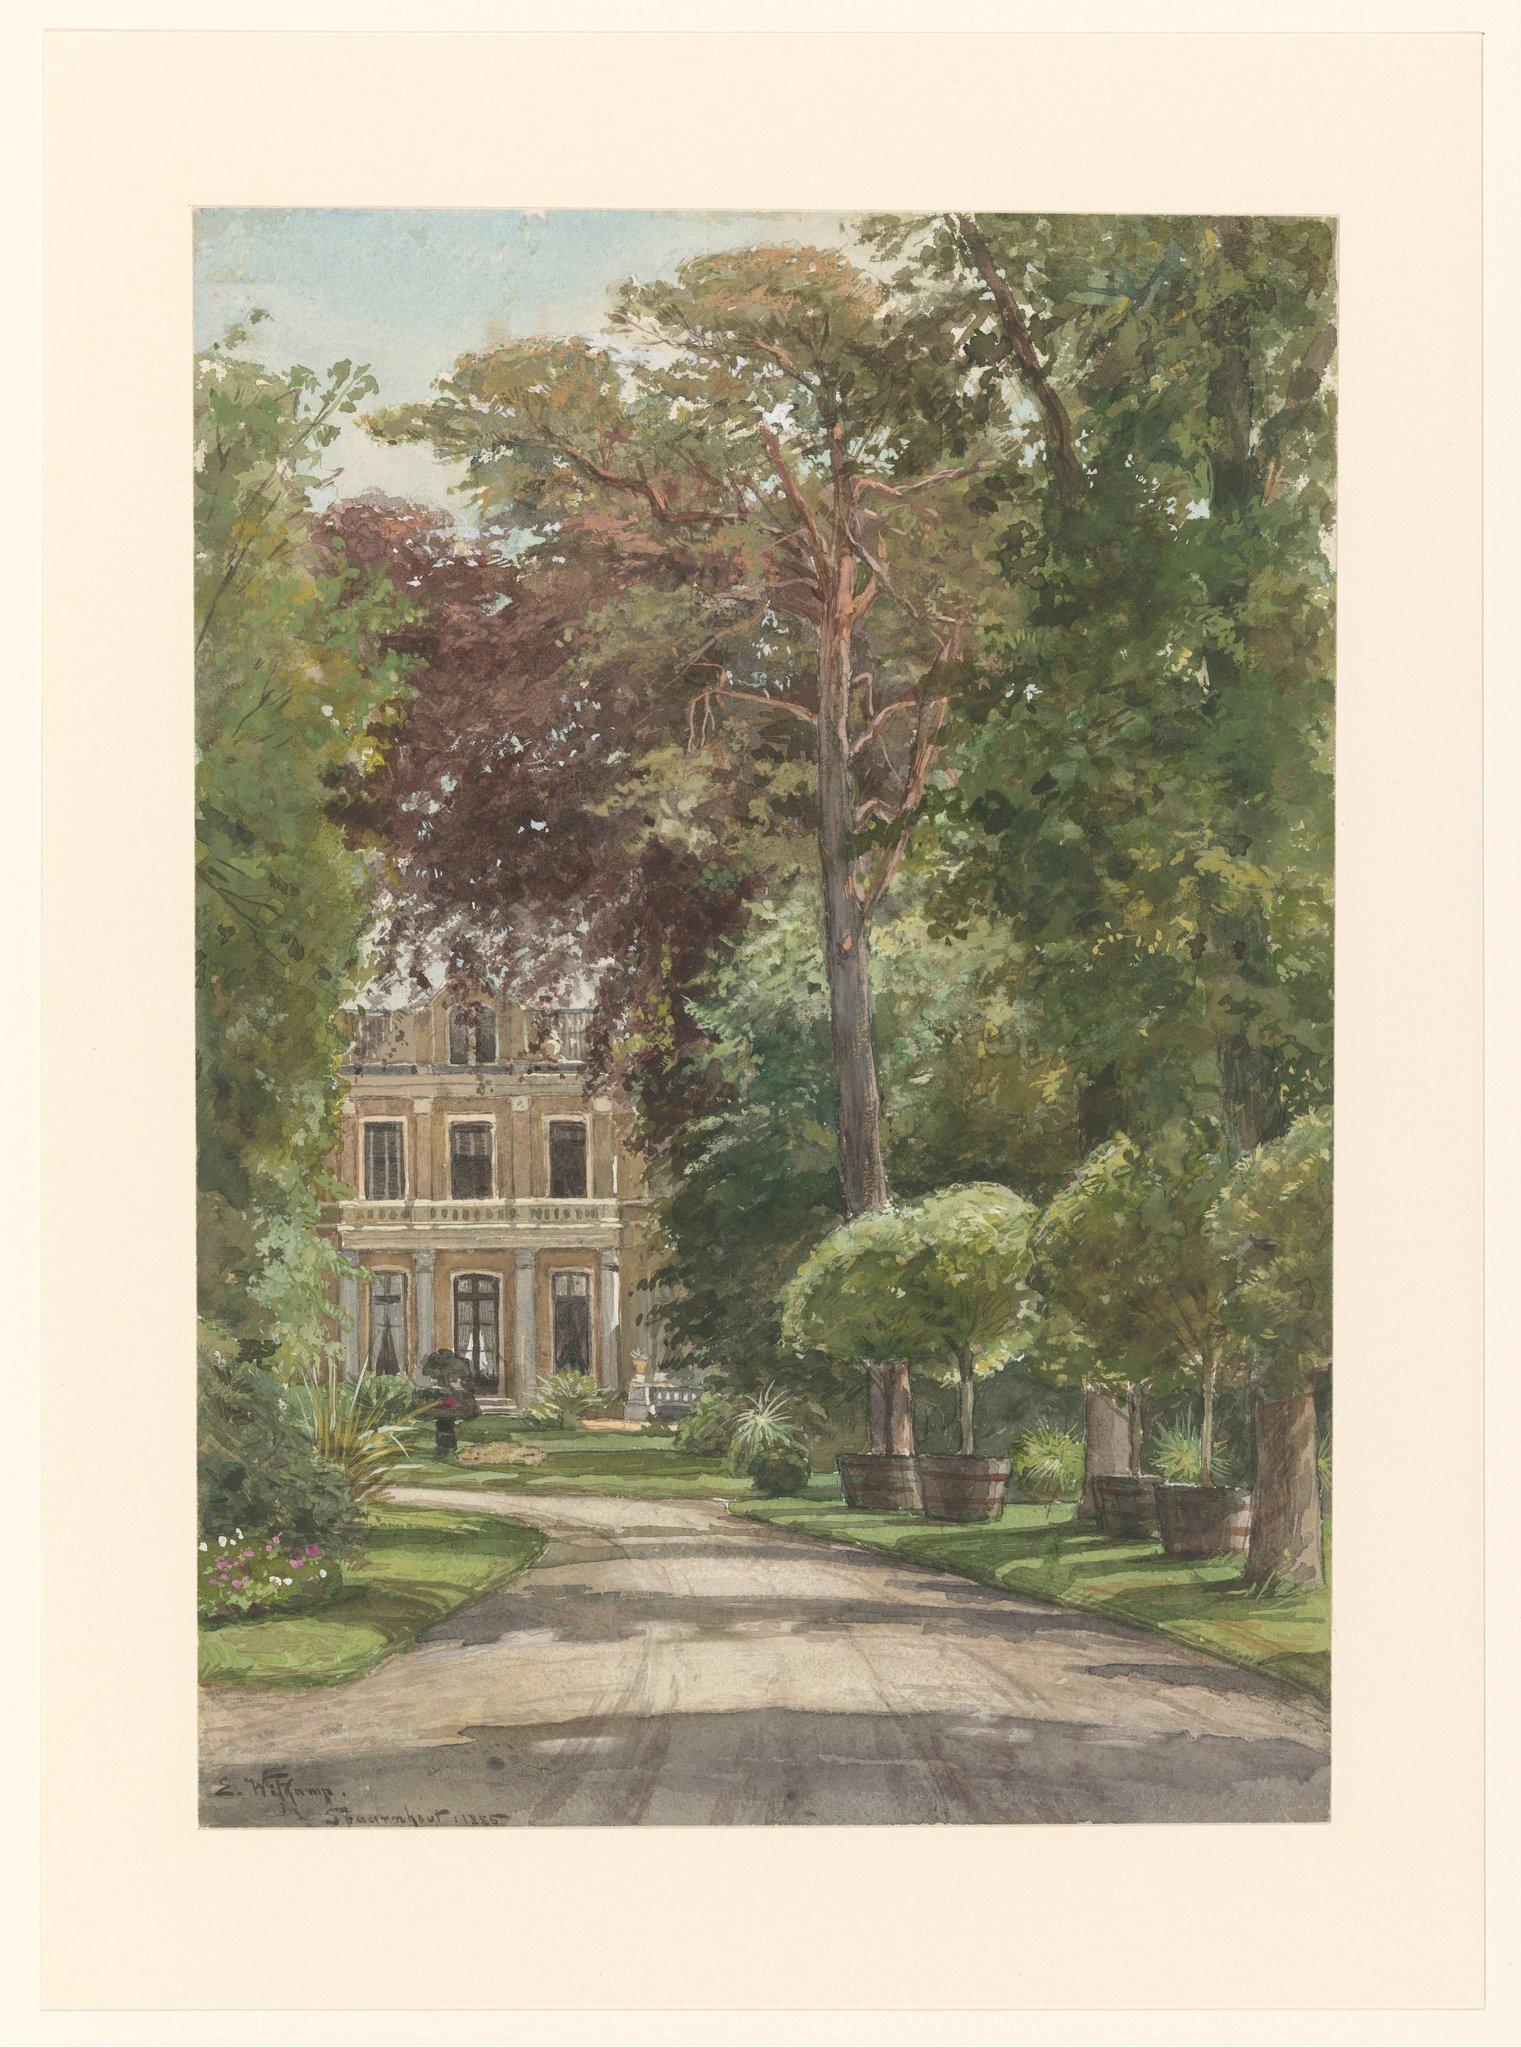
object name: watercolor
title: Het buiten Spaarnhout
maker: ernst witkamp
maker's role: draughtsman, print maker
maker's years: 1854-1897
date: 1885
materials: paper, watercolor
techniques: brush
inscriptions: date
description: Gezicht op het huis Spaarnhout door de oprijlaan.